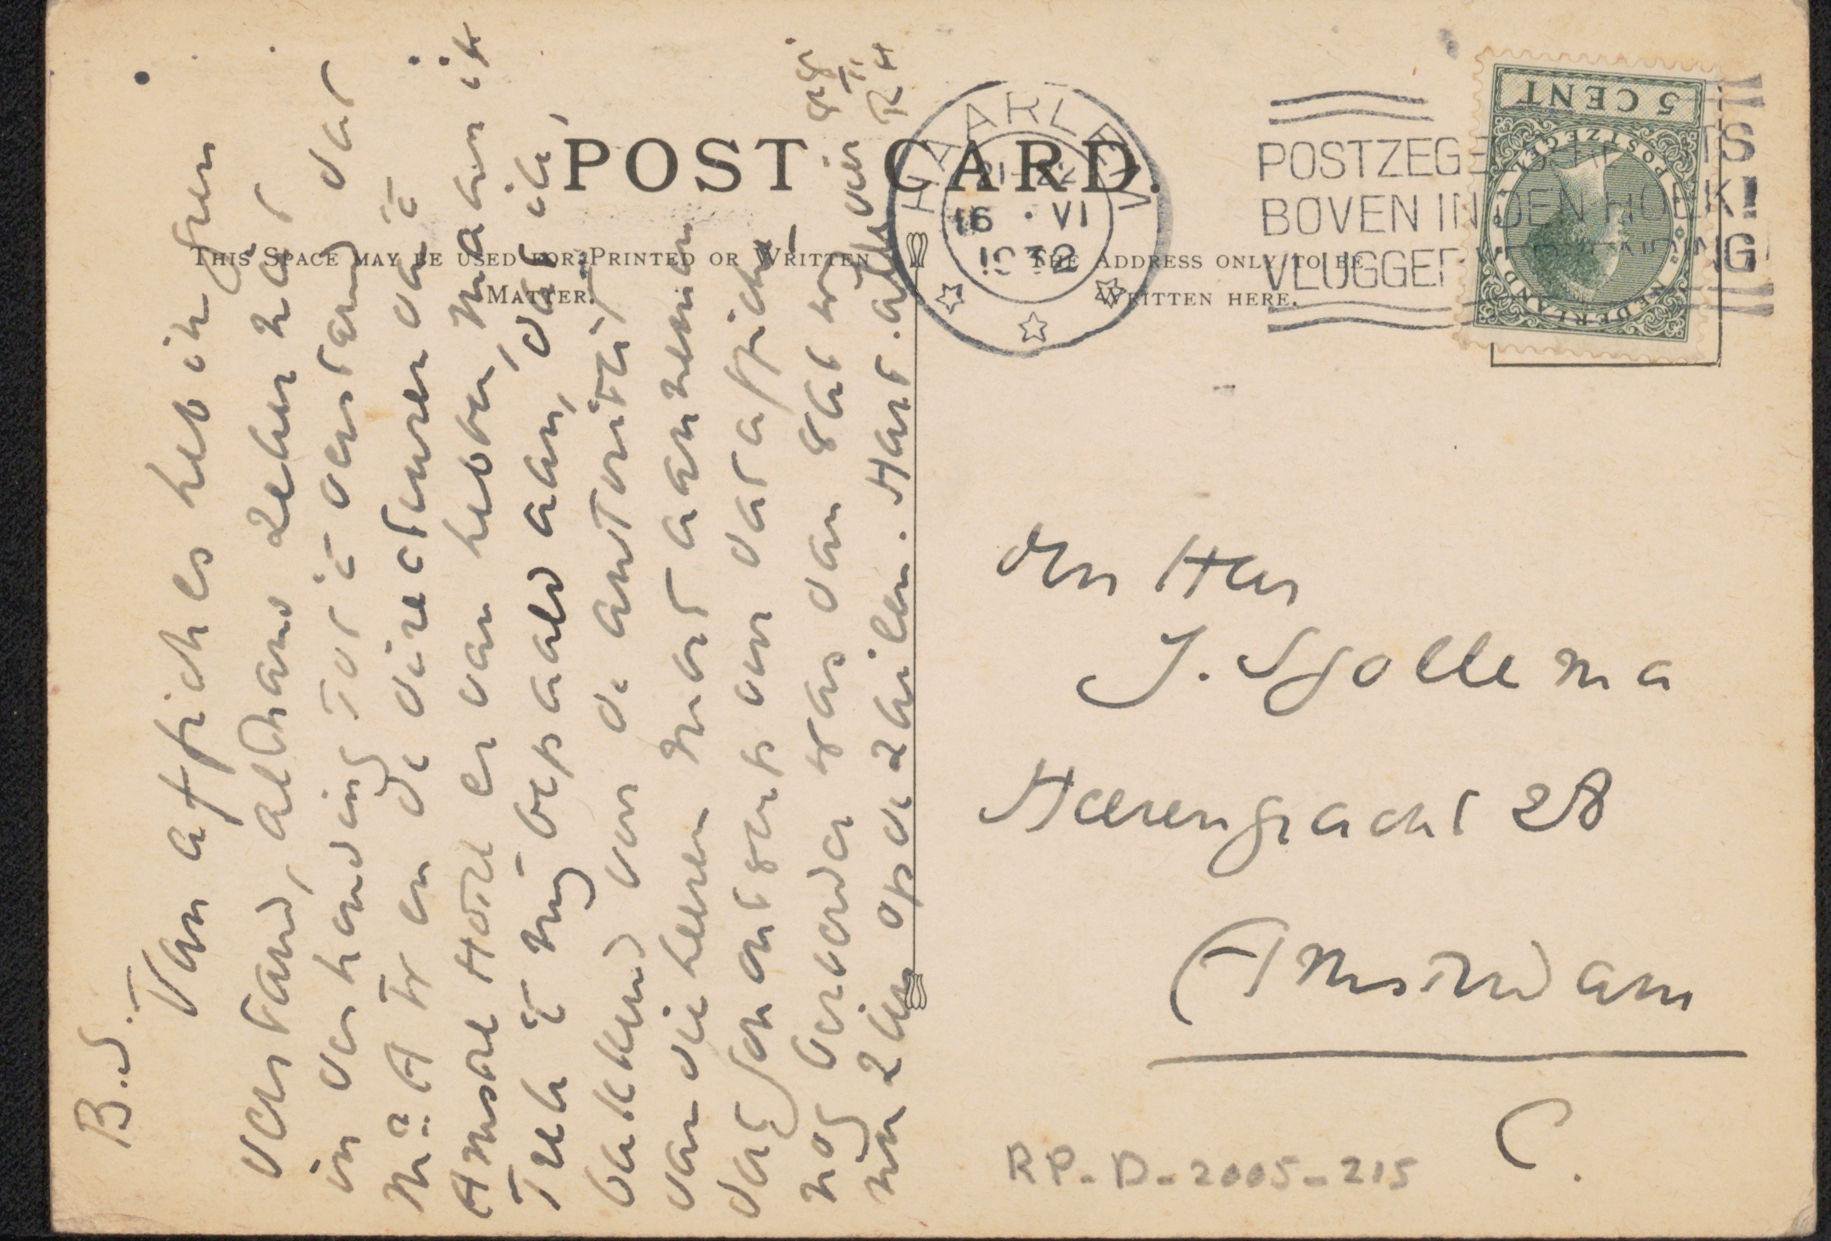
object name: ansichtkaart, prentbriefkaart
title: Prentbriefkaart aan Joop Sjollema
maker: richard nicolaüs roland holst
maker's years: 1868-1938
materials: cardboard, ink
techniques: pen, printing, writing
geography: haarlem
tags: amsterdam, print maker, draughtsman, joop sjollema, the graphic arts